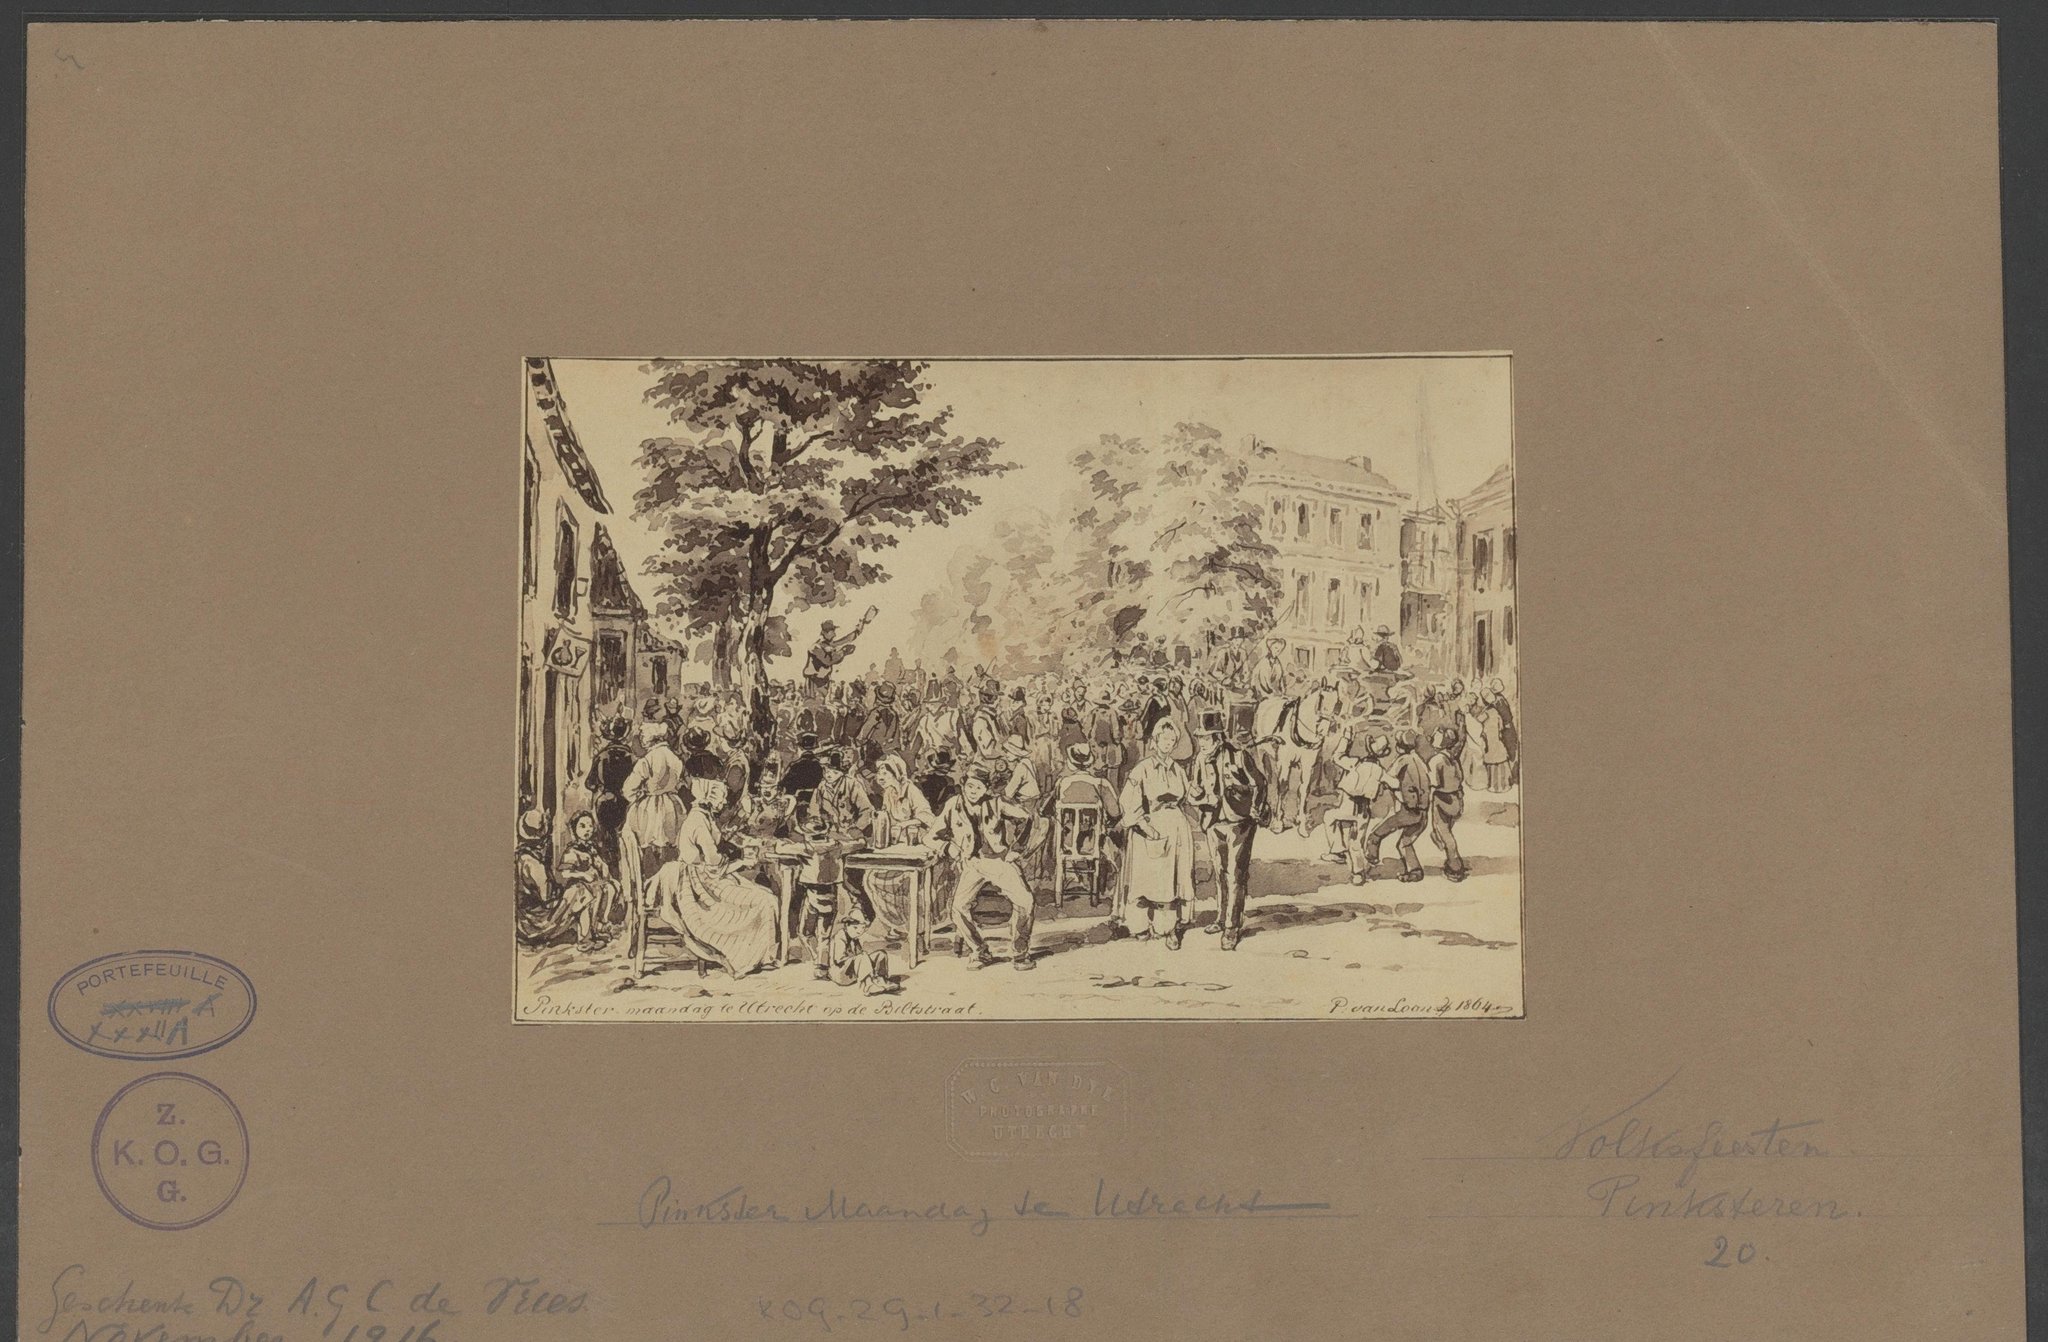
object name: reproduction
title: Fotoreproductie van een tekening van Pinkstermaandag te Utrecht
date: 1864-1881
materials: photographic support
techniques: gelatin silver print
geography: utrecht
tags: pentecost, whitsunday, pavement, terrace in front of inn or restaurant, pleasure fair and circus, calendar festivals, non-liturgical celebrations of days belonging to the ecclesiastical calendar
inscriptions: collector's mark: Lugt 1641, collector's mark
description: Tekening van de viering van Pinkstermaandag in de Biltstraat te Utrecht, in 1864. Plein met een vol terras, een spreker op een podium en dansende jongeren. Onderwerpsrubrieken binnen de Atlas Zeden en Gewoonten: Volksfeesten; Pinksteren.